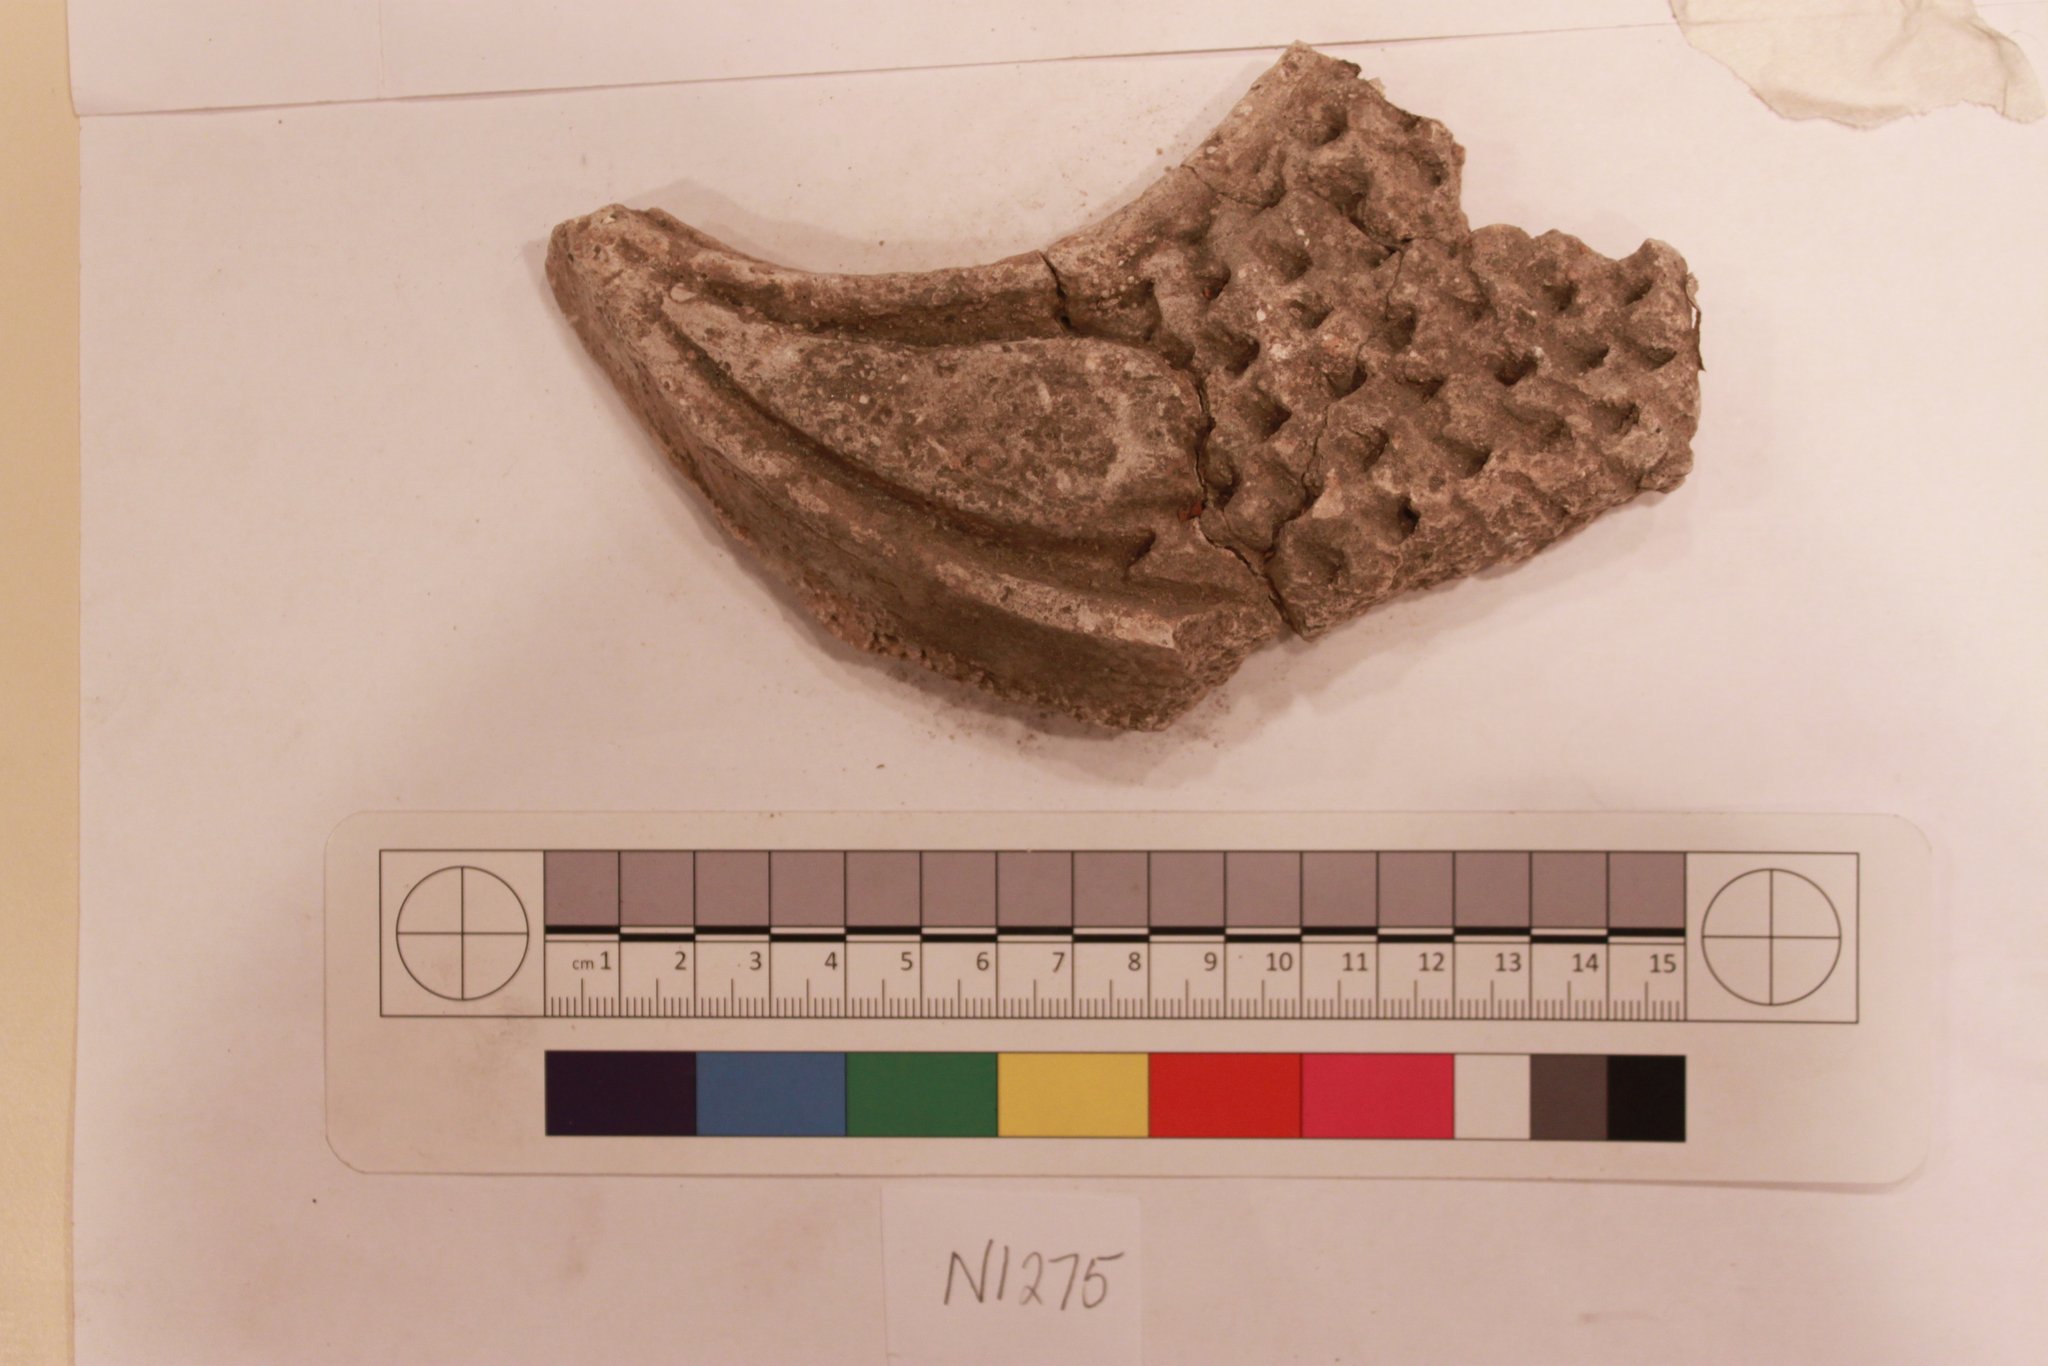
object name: fragment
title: Stucco Fragment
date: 701-1200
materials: plaster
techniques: carving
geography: iran